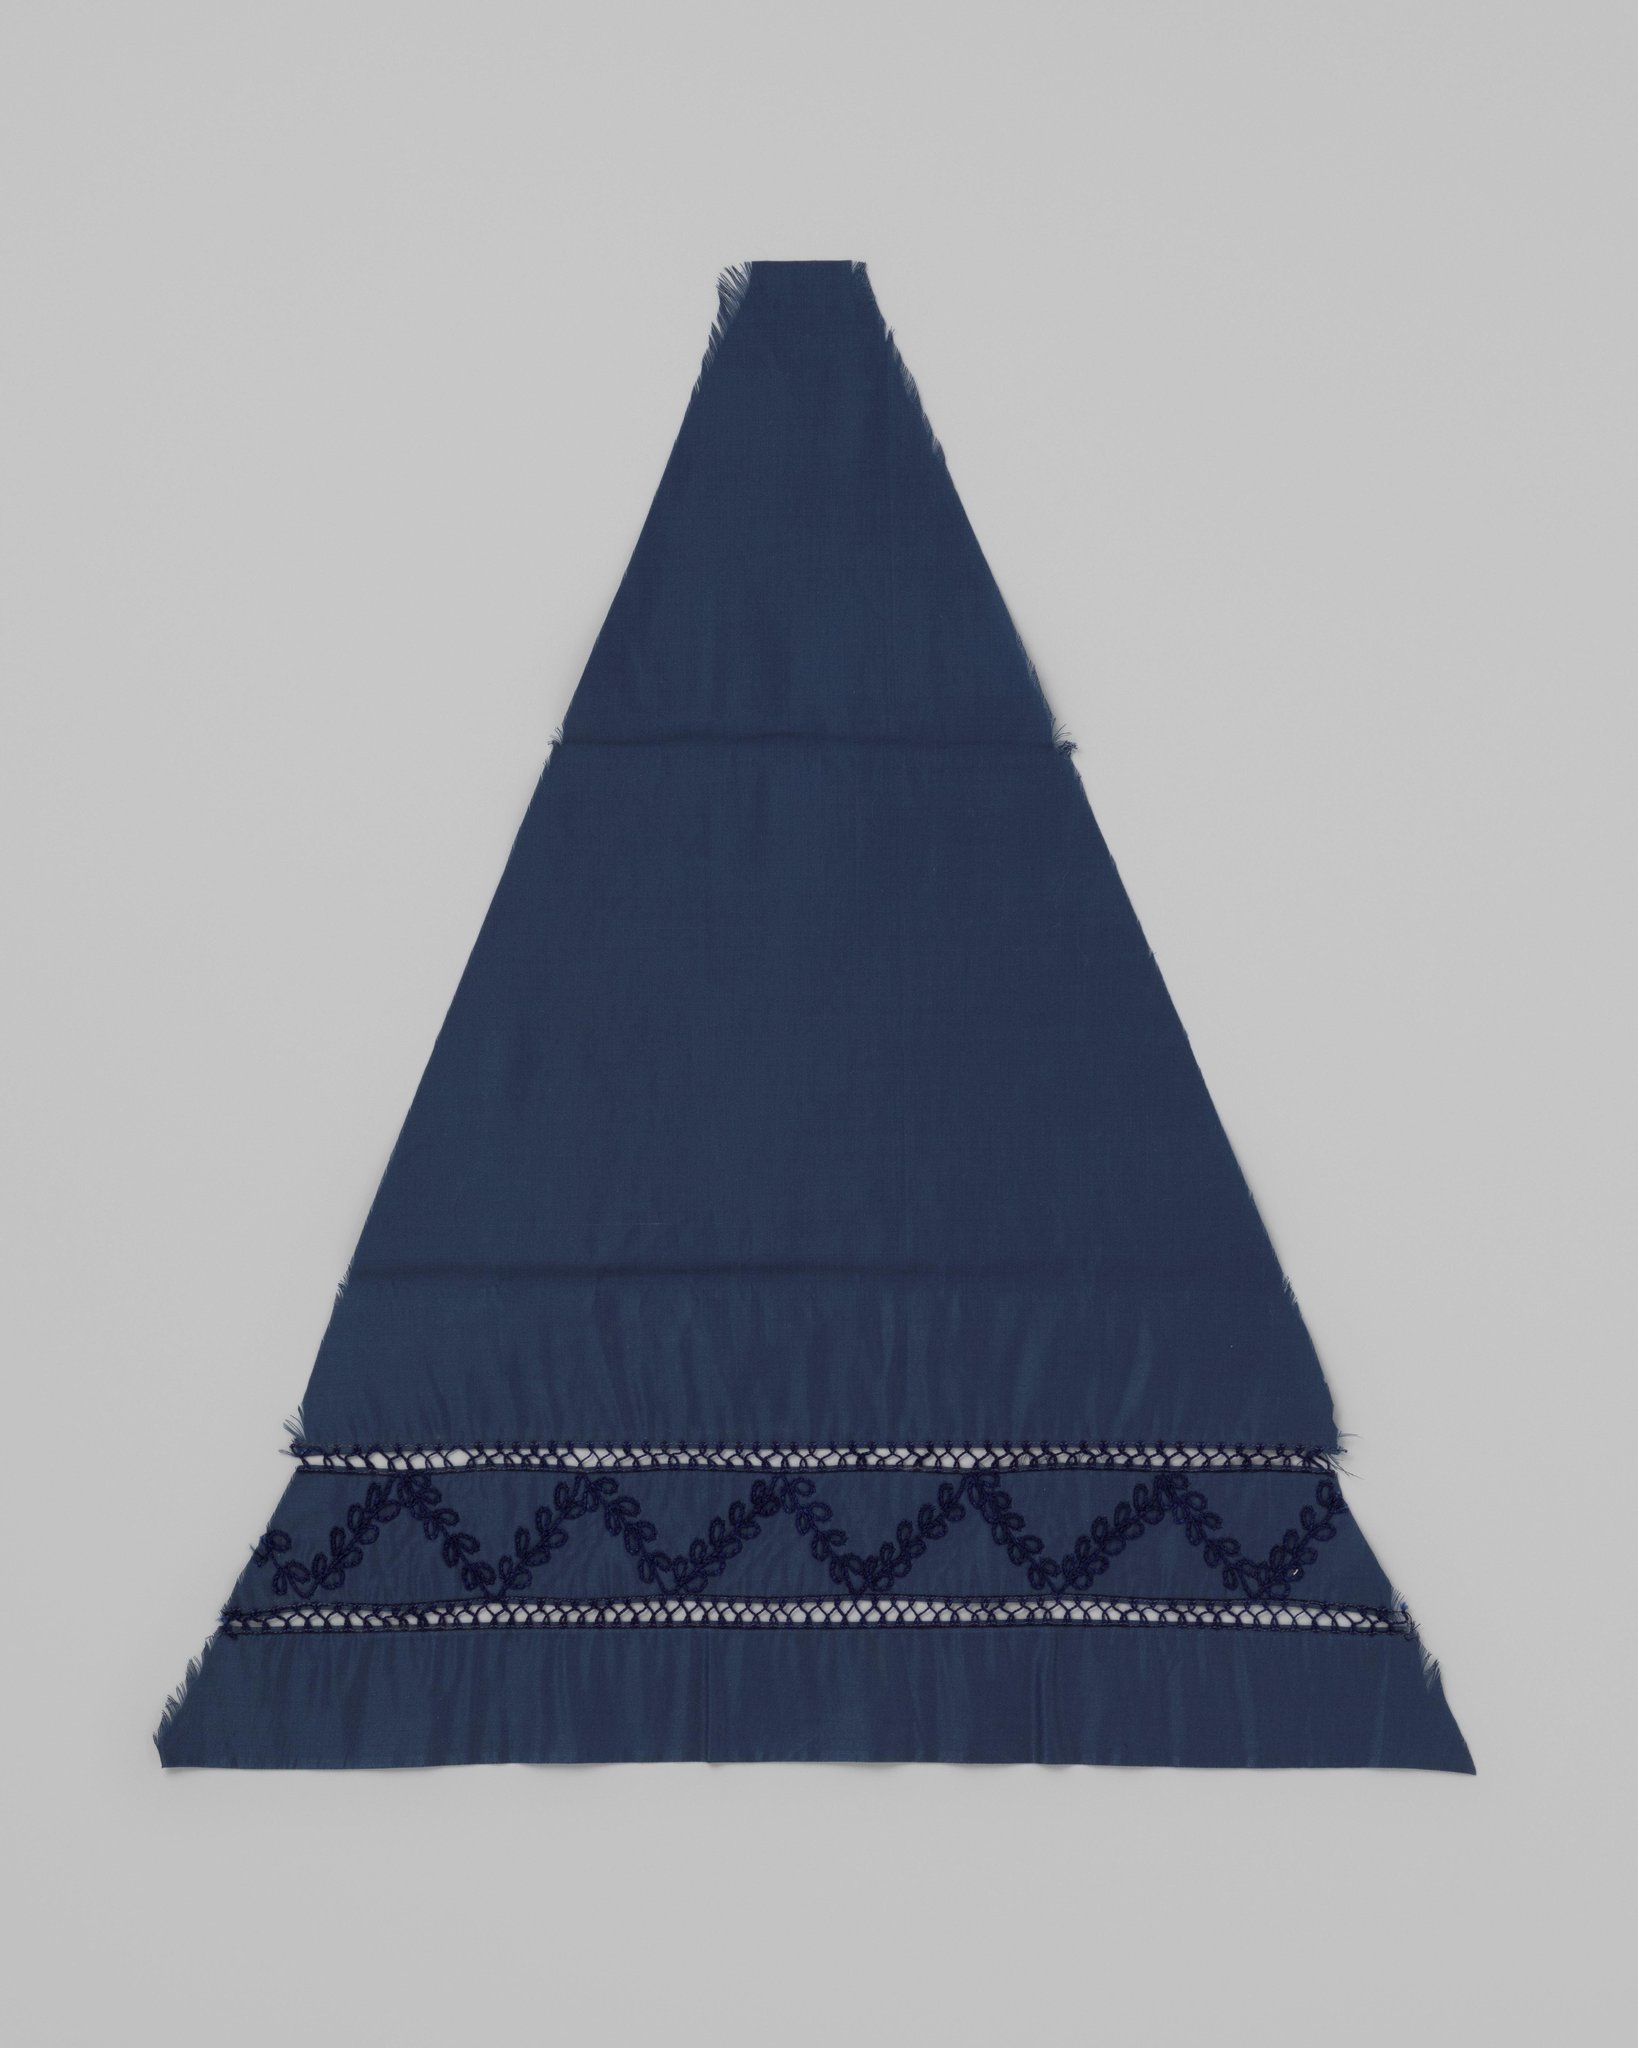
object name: parasoldek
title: Sector van een parasoldek van donkerblauwe katoen, versierd met borduurwerk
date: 1885-1900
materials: cotton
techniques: embroidered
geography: nijmegen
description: Sector van een parasoldek van donkerblauwe katoen, versierd met borduurwerk. Het borduurwerk bestaat uit twee rijen stiksteken doorgeregen met een flanelsteek, waartussen een slingerende bladrank. Aan het dek is een etiket bevestigd met een metalen klem.